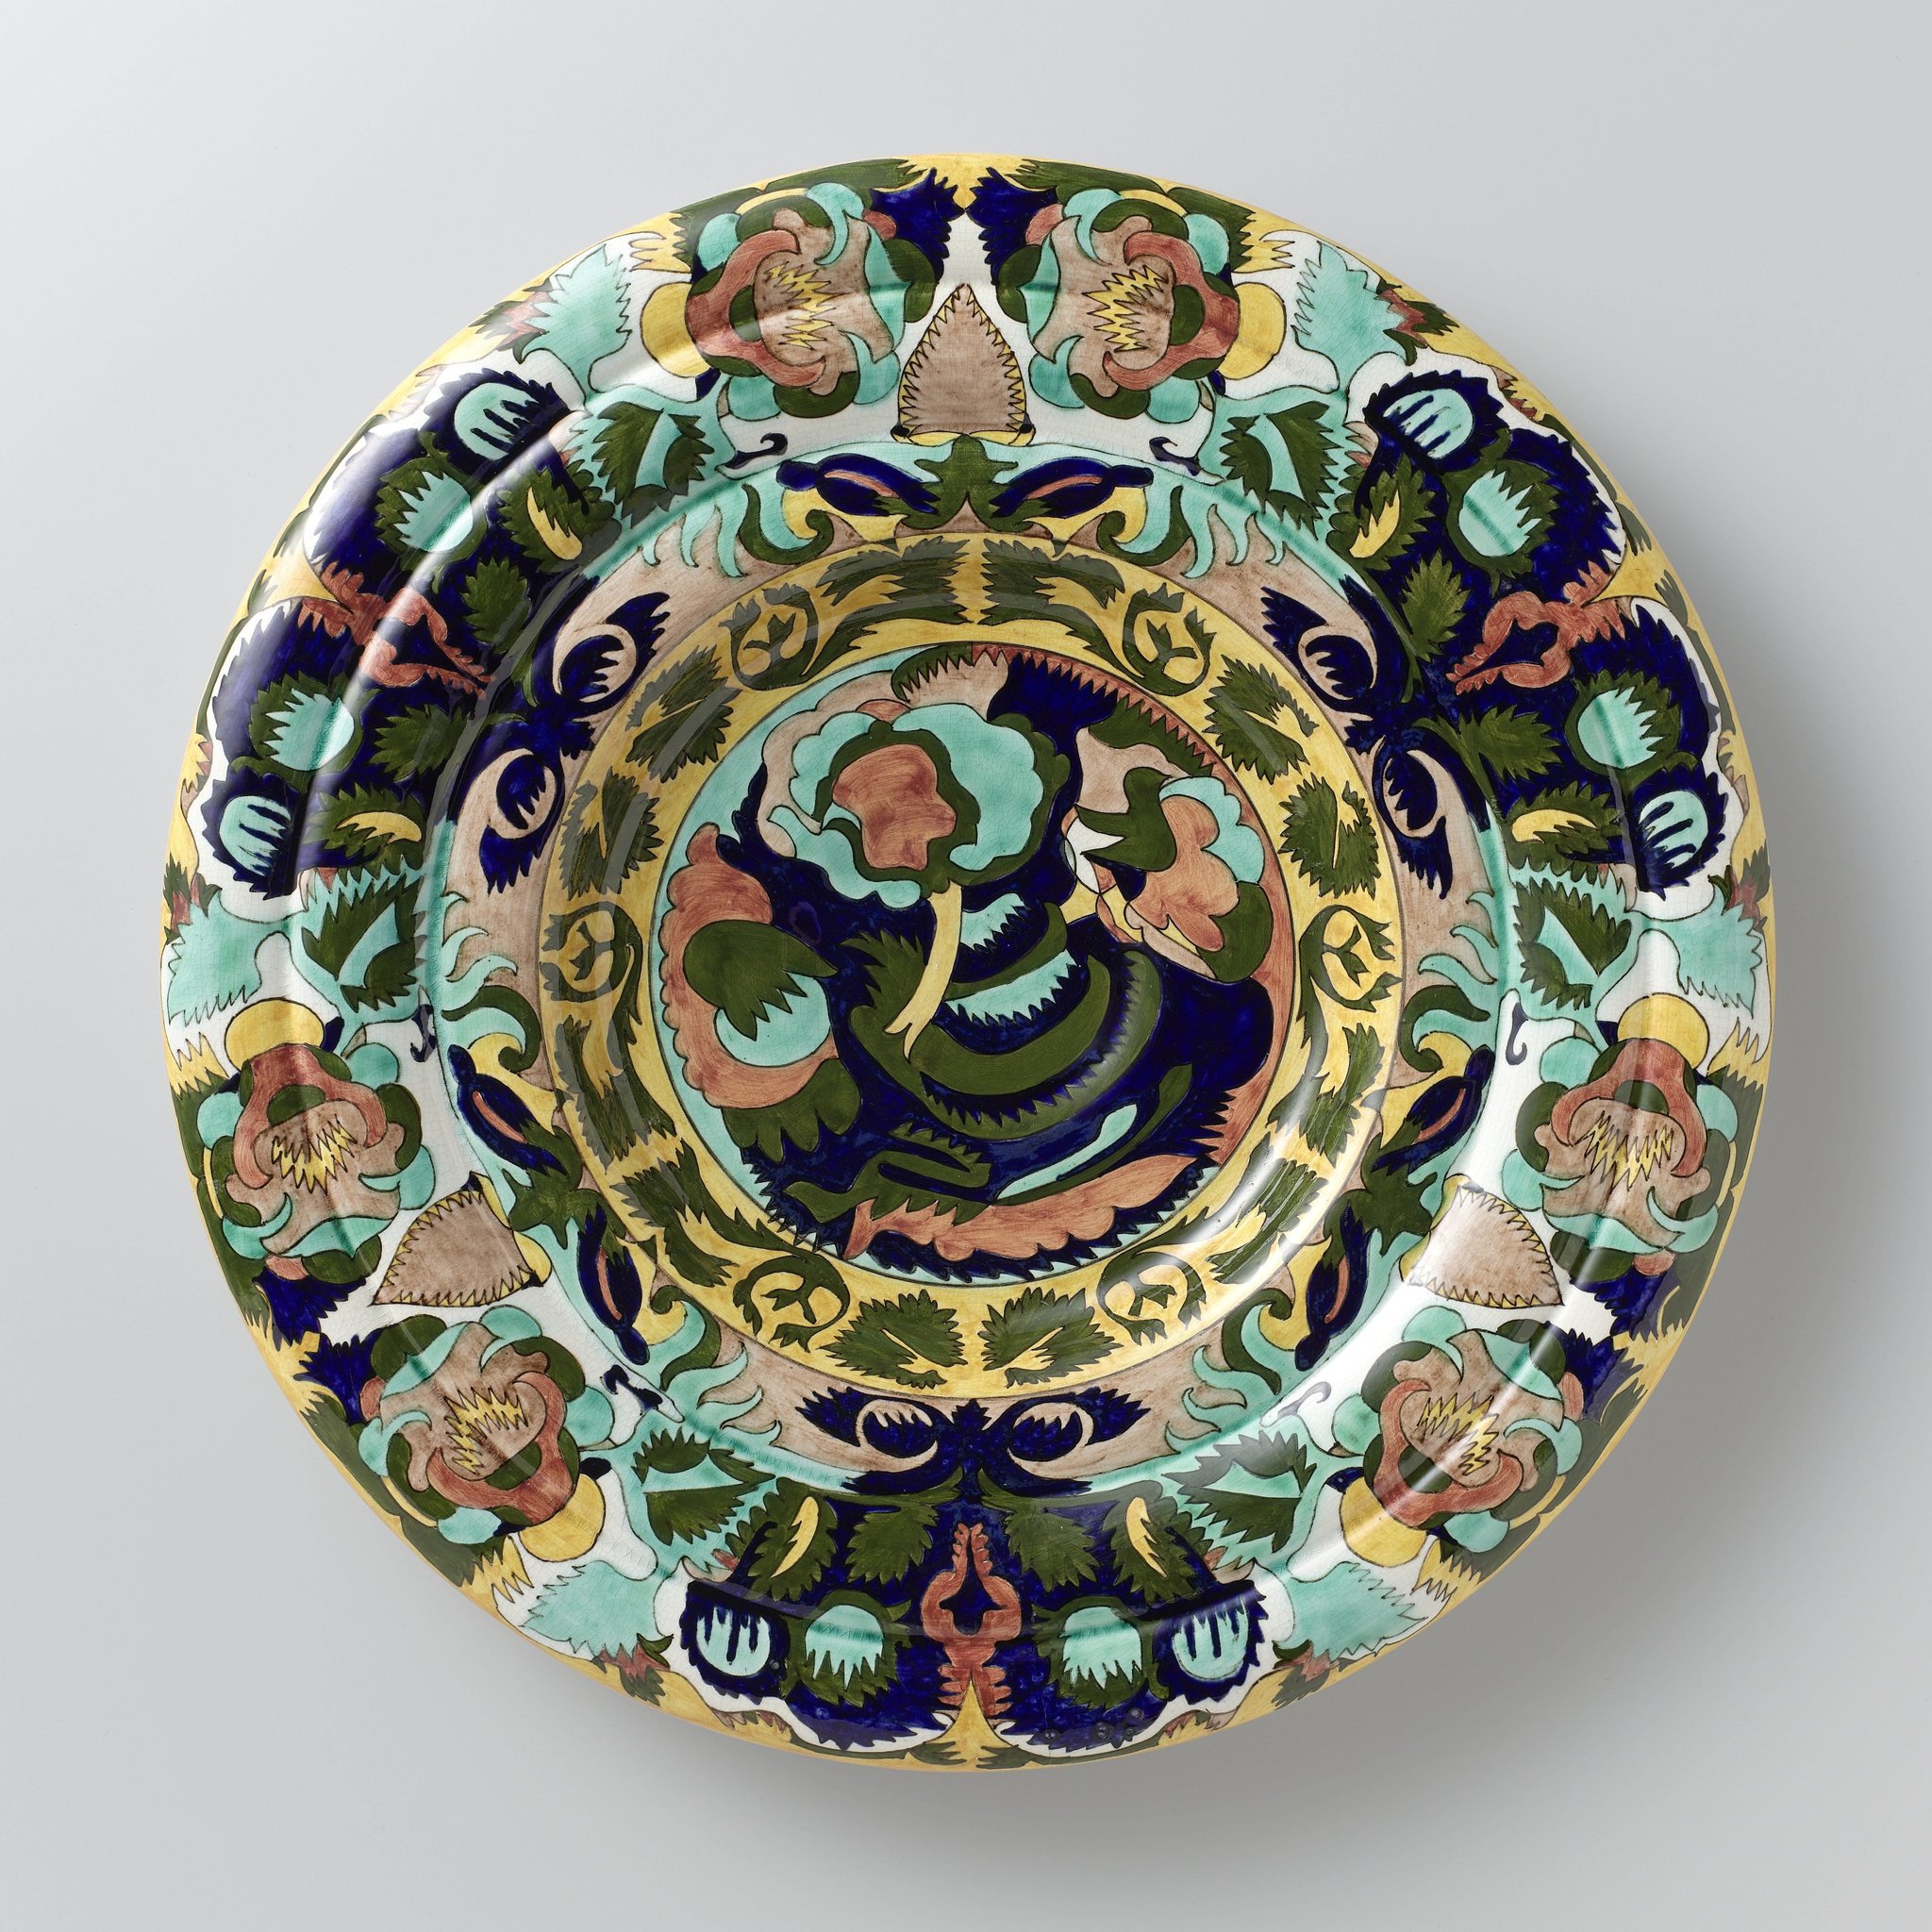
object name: plate dish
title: Decorative plate with plant motifs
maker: theo colenbrander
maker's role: draughtsman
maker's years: 1841-1930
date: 1886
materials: earthenware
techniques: painted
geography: the hague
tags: flowers ~ ornament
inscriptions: mark: ‘W v met vlag G / Haag / B.’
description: Schotel van aardewerk, geribd, polychroom beschilderd met een decor van plantenmotieven. De kleuren zijn geel, licht- en donkergroen, licht- en donkerblauw, roze en lichtbruin. Ophanggaten in voetring. Gemerkt met: W v met vlag G / Haag / B.